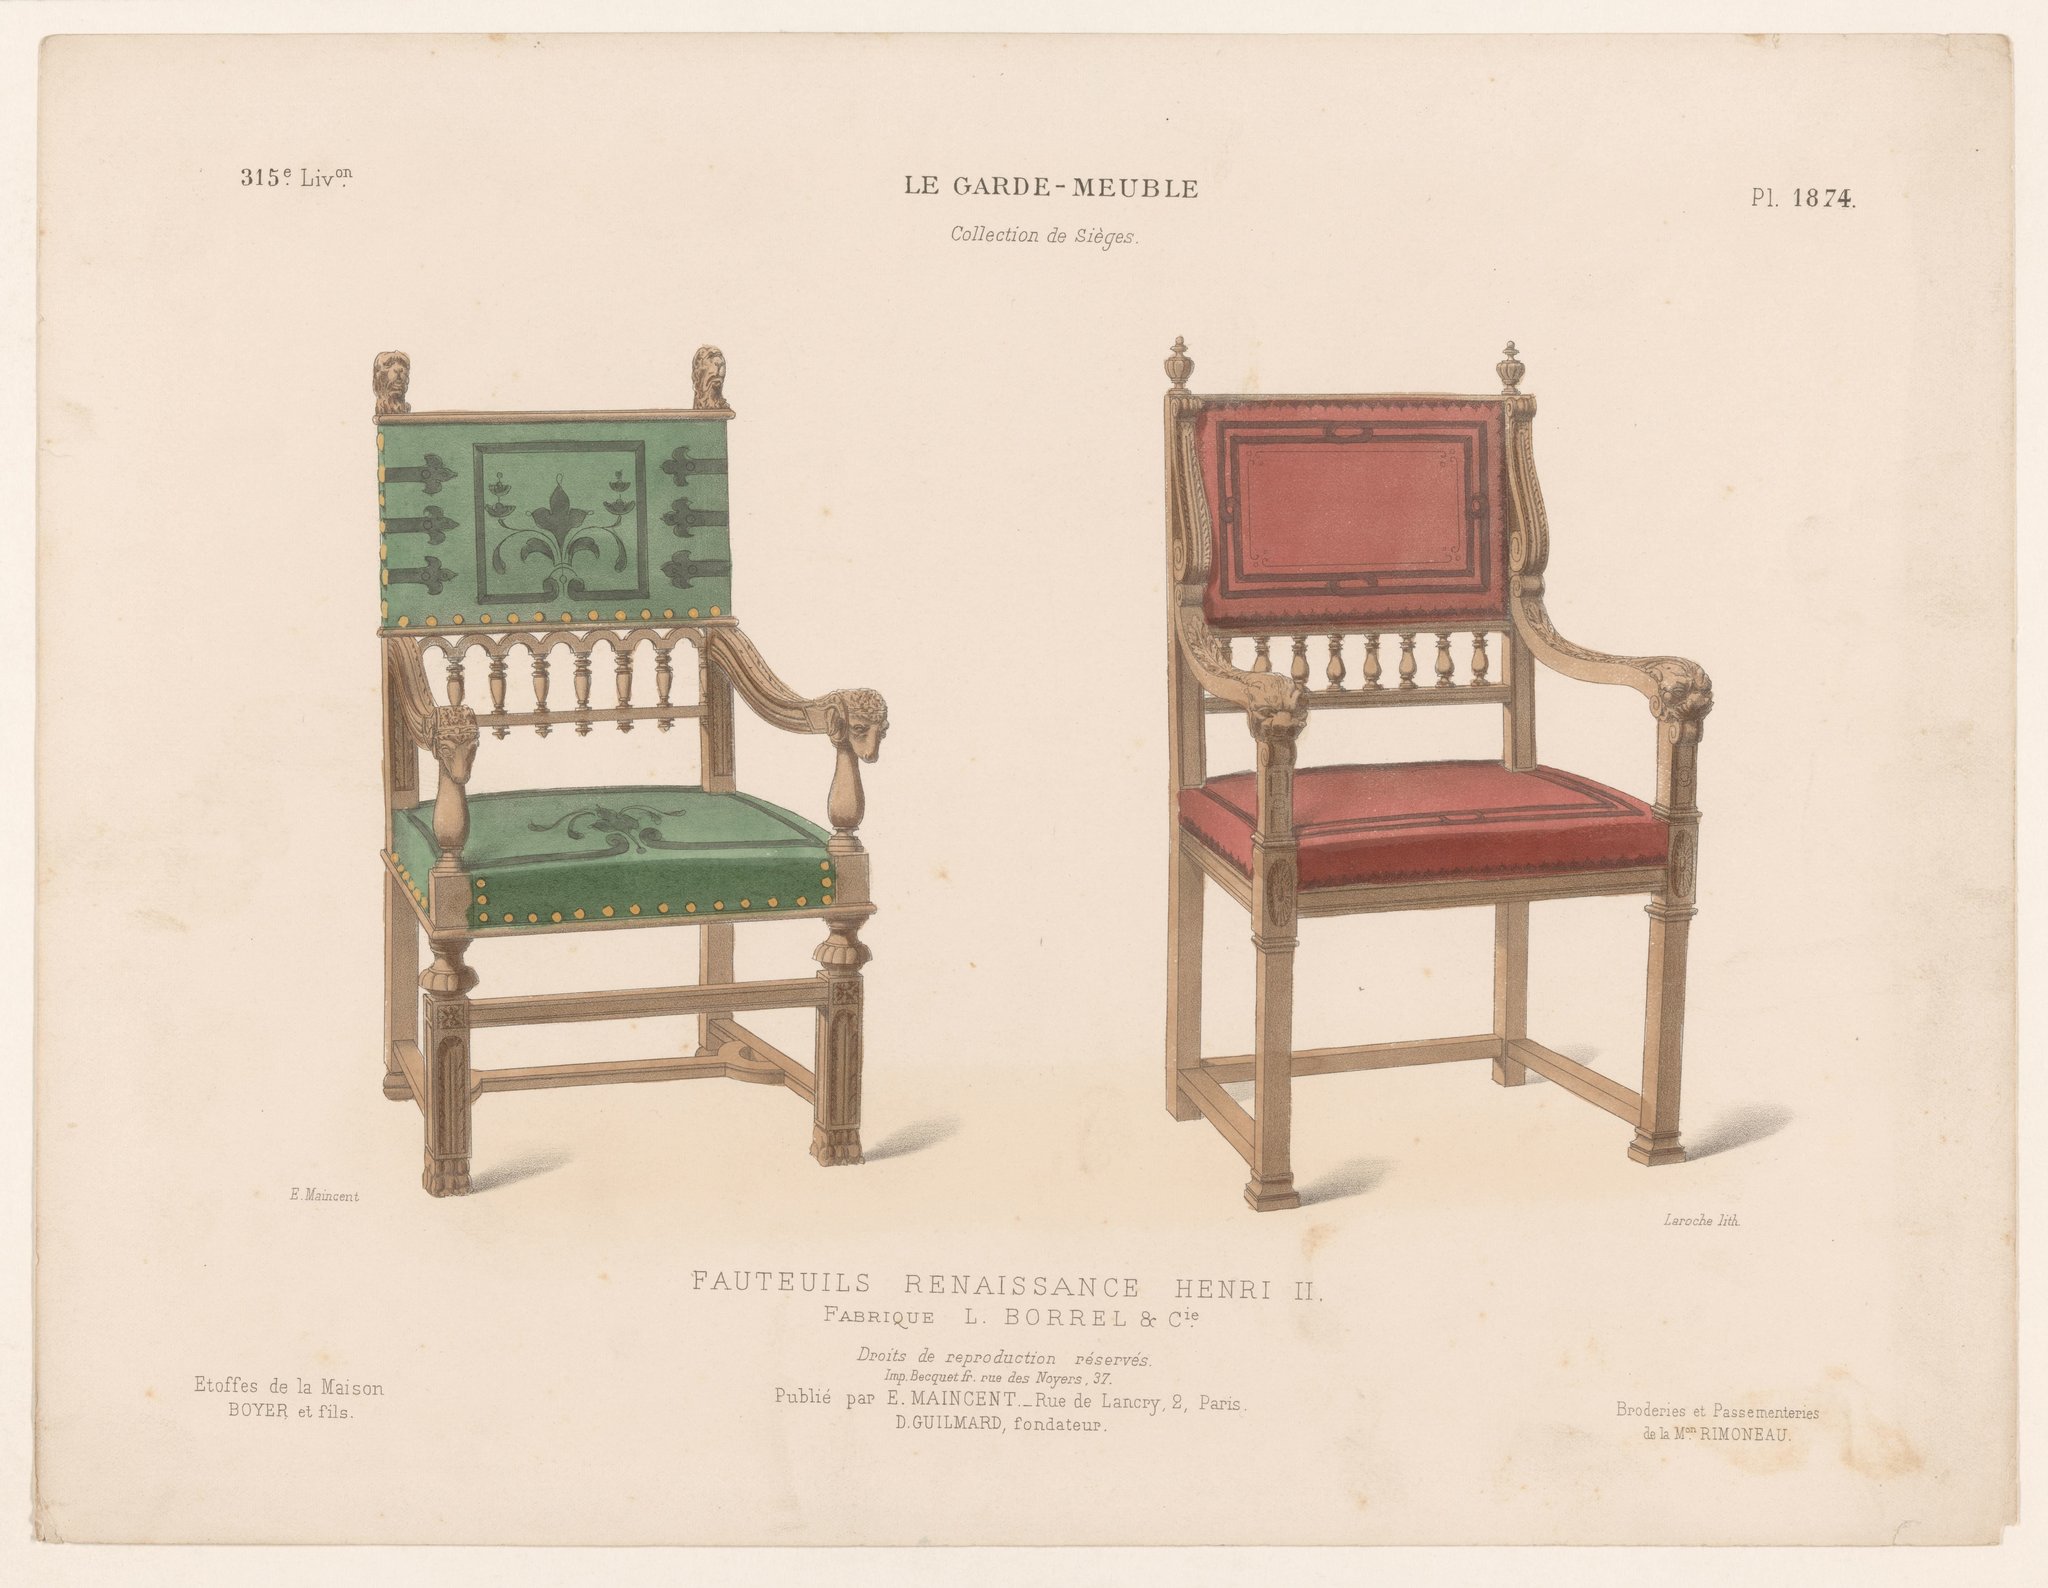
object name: print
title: Fauteuils renaissance Henri II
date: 1885-1895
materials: paper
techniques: hand coloring, lithograph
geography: paris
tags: seating furniture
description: Ieder Livraison in de serie Le Garde-Meuble bevat negen platen: drie 'sièges' (zitmeubels), drie 'meubles' (diverse meubels zoals tafels en kasten) en drie 'tentures' (gordijnen en draperieën).